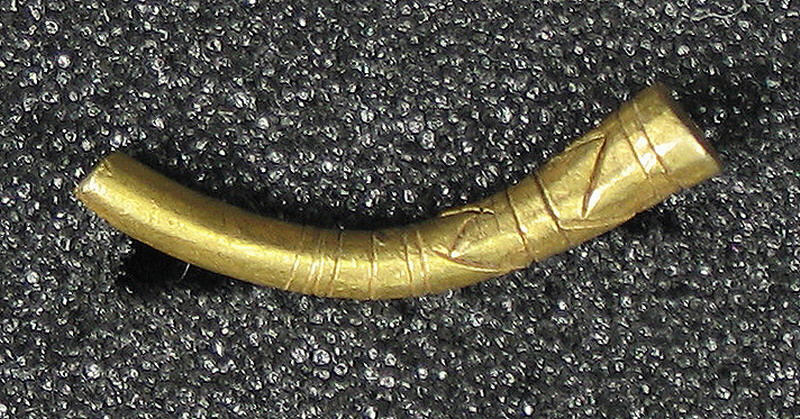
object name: ornament fragment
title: Fragment of an Ornament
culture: indonesian, central java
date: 701-1200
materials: gold